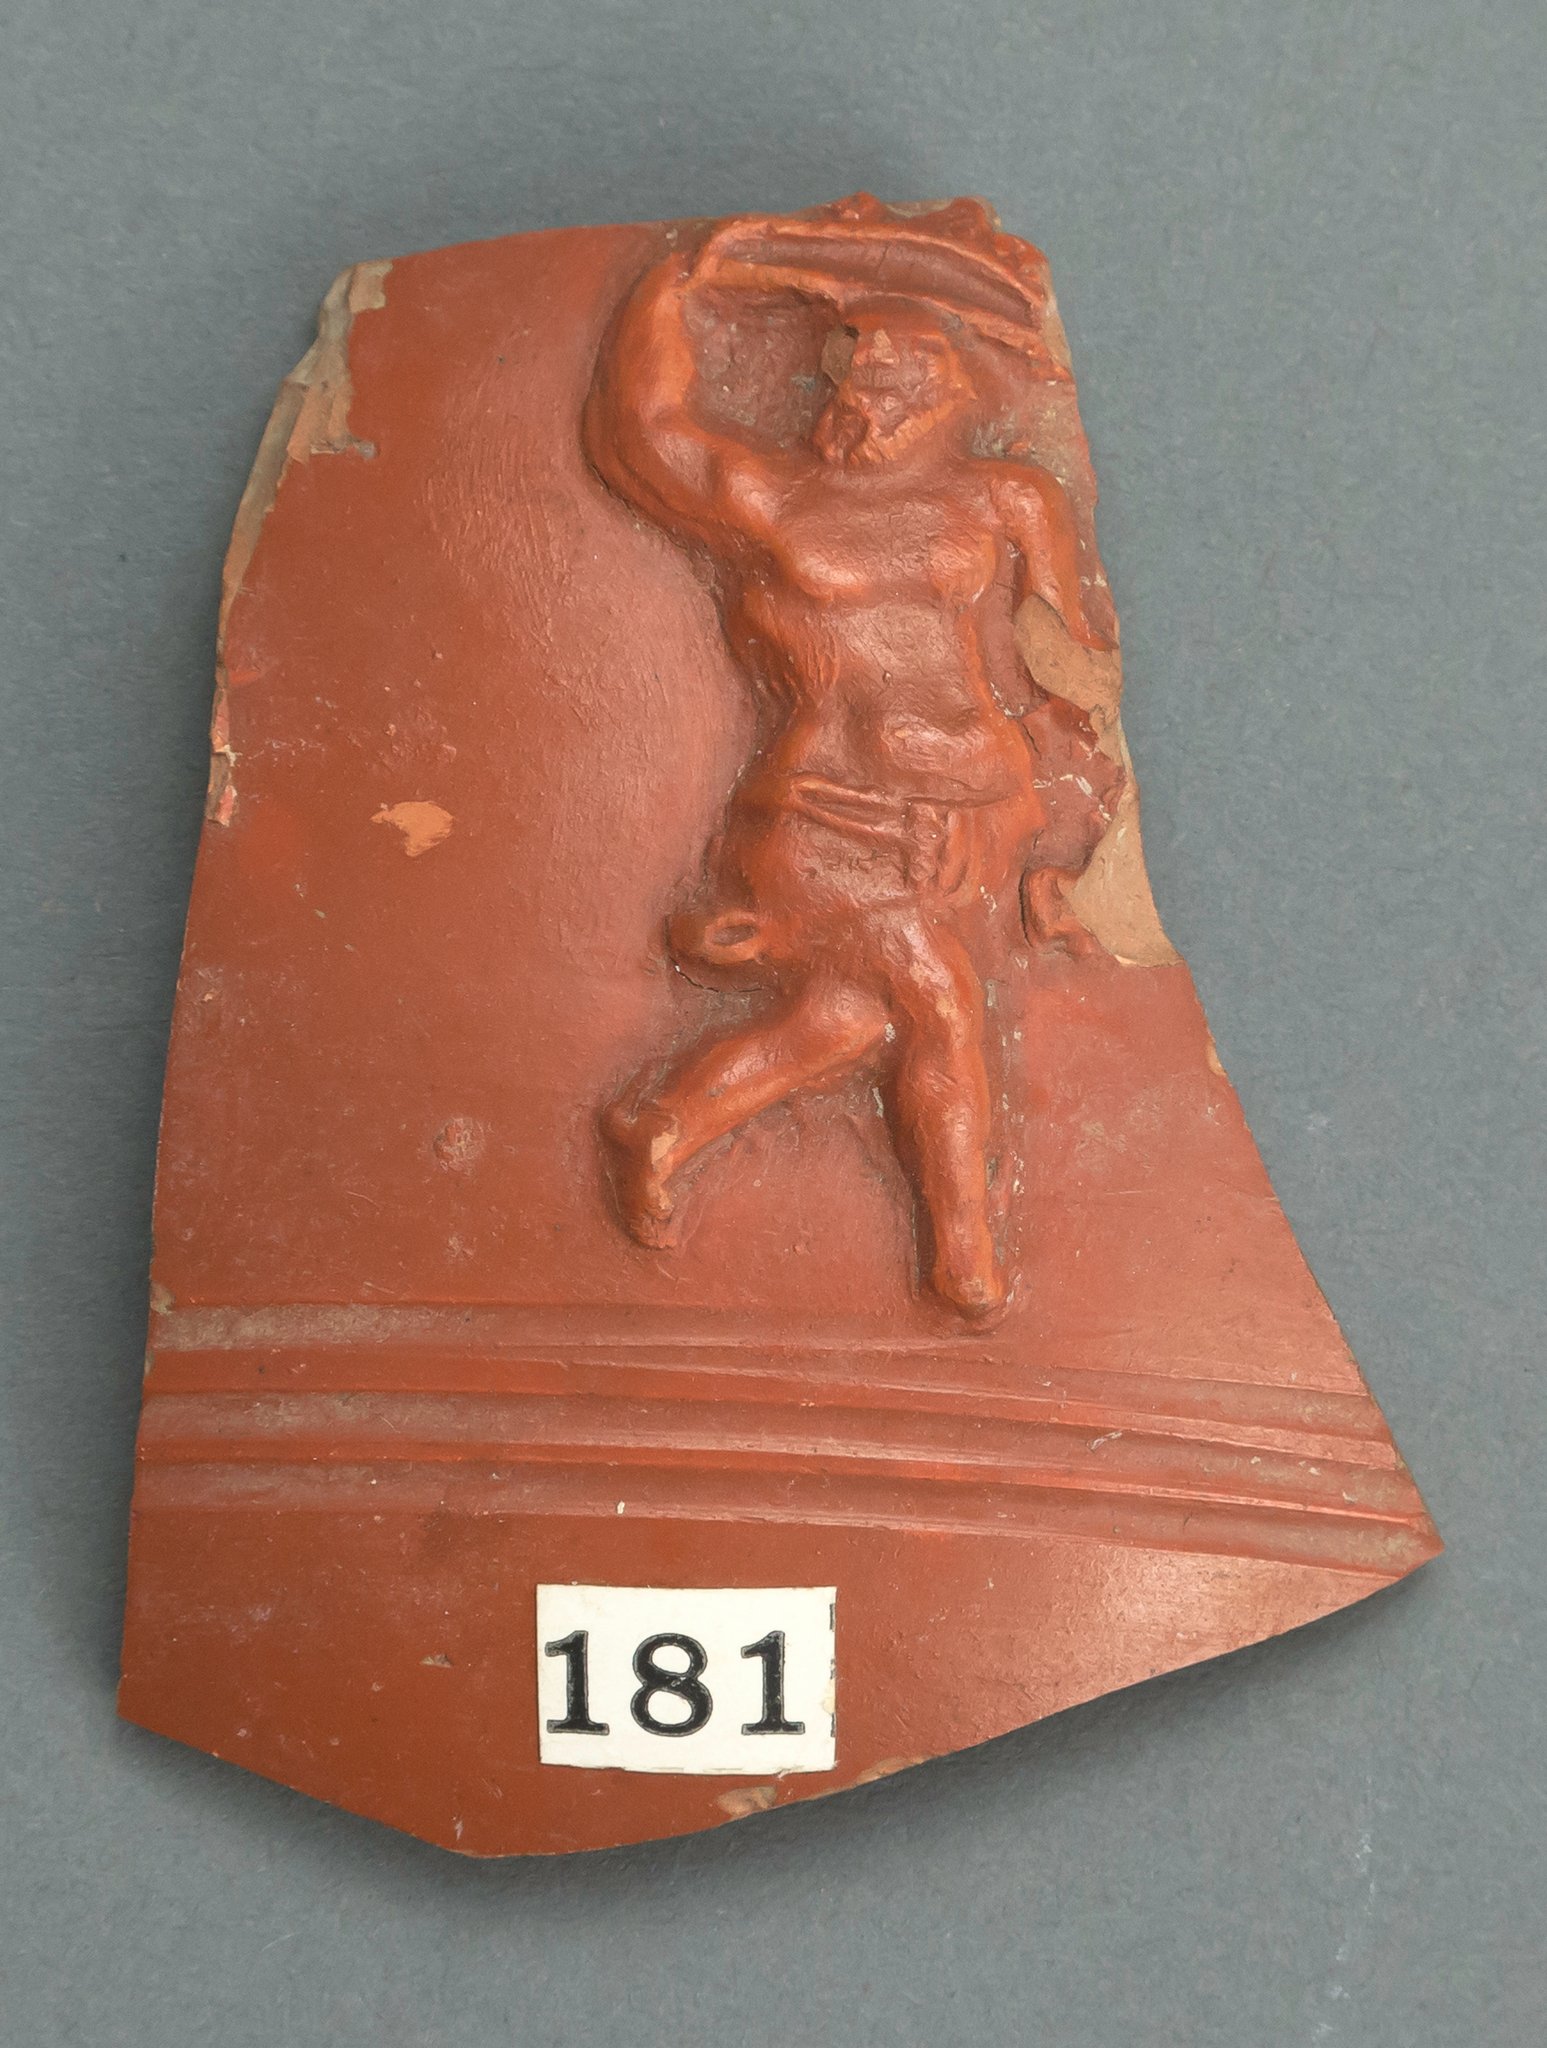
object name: vase fragment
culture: roman, gaul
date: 120 BCE-300 CE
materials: terracotta